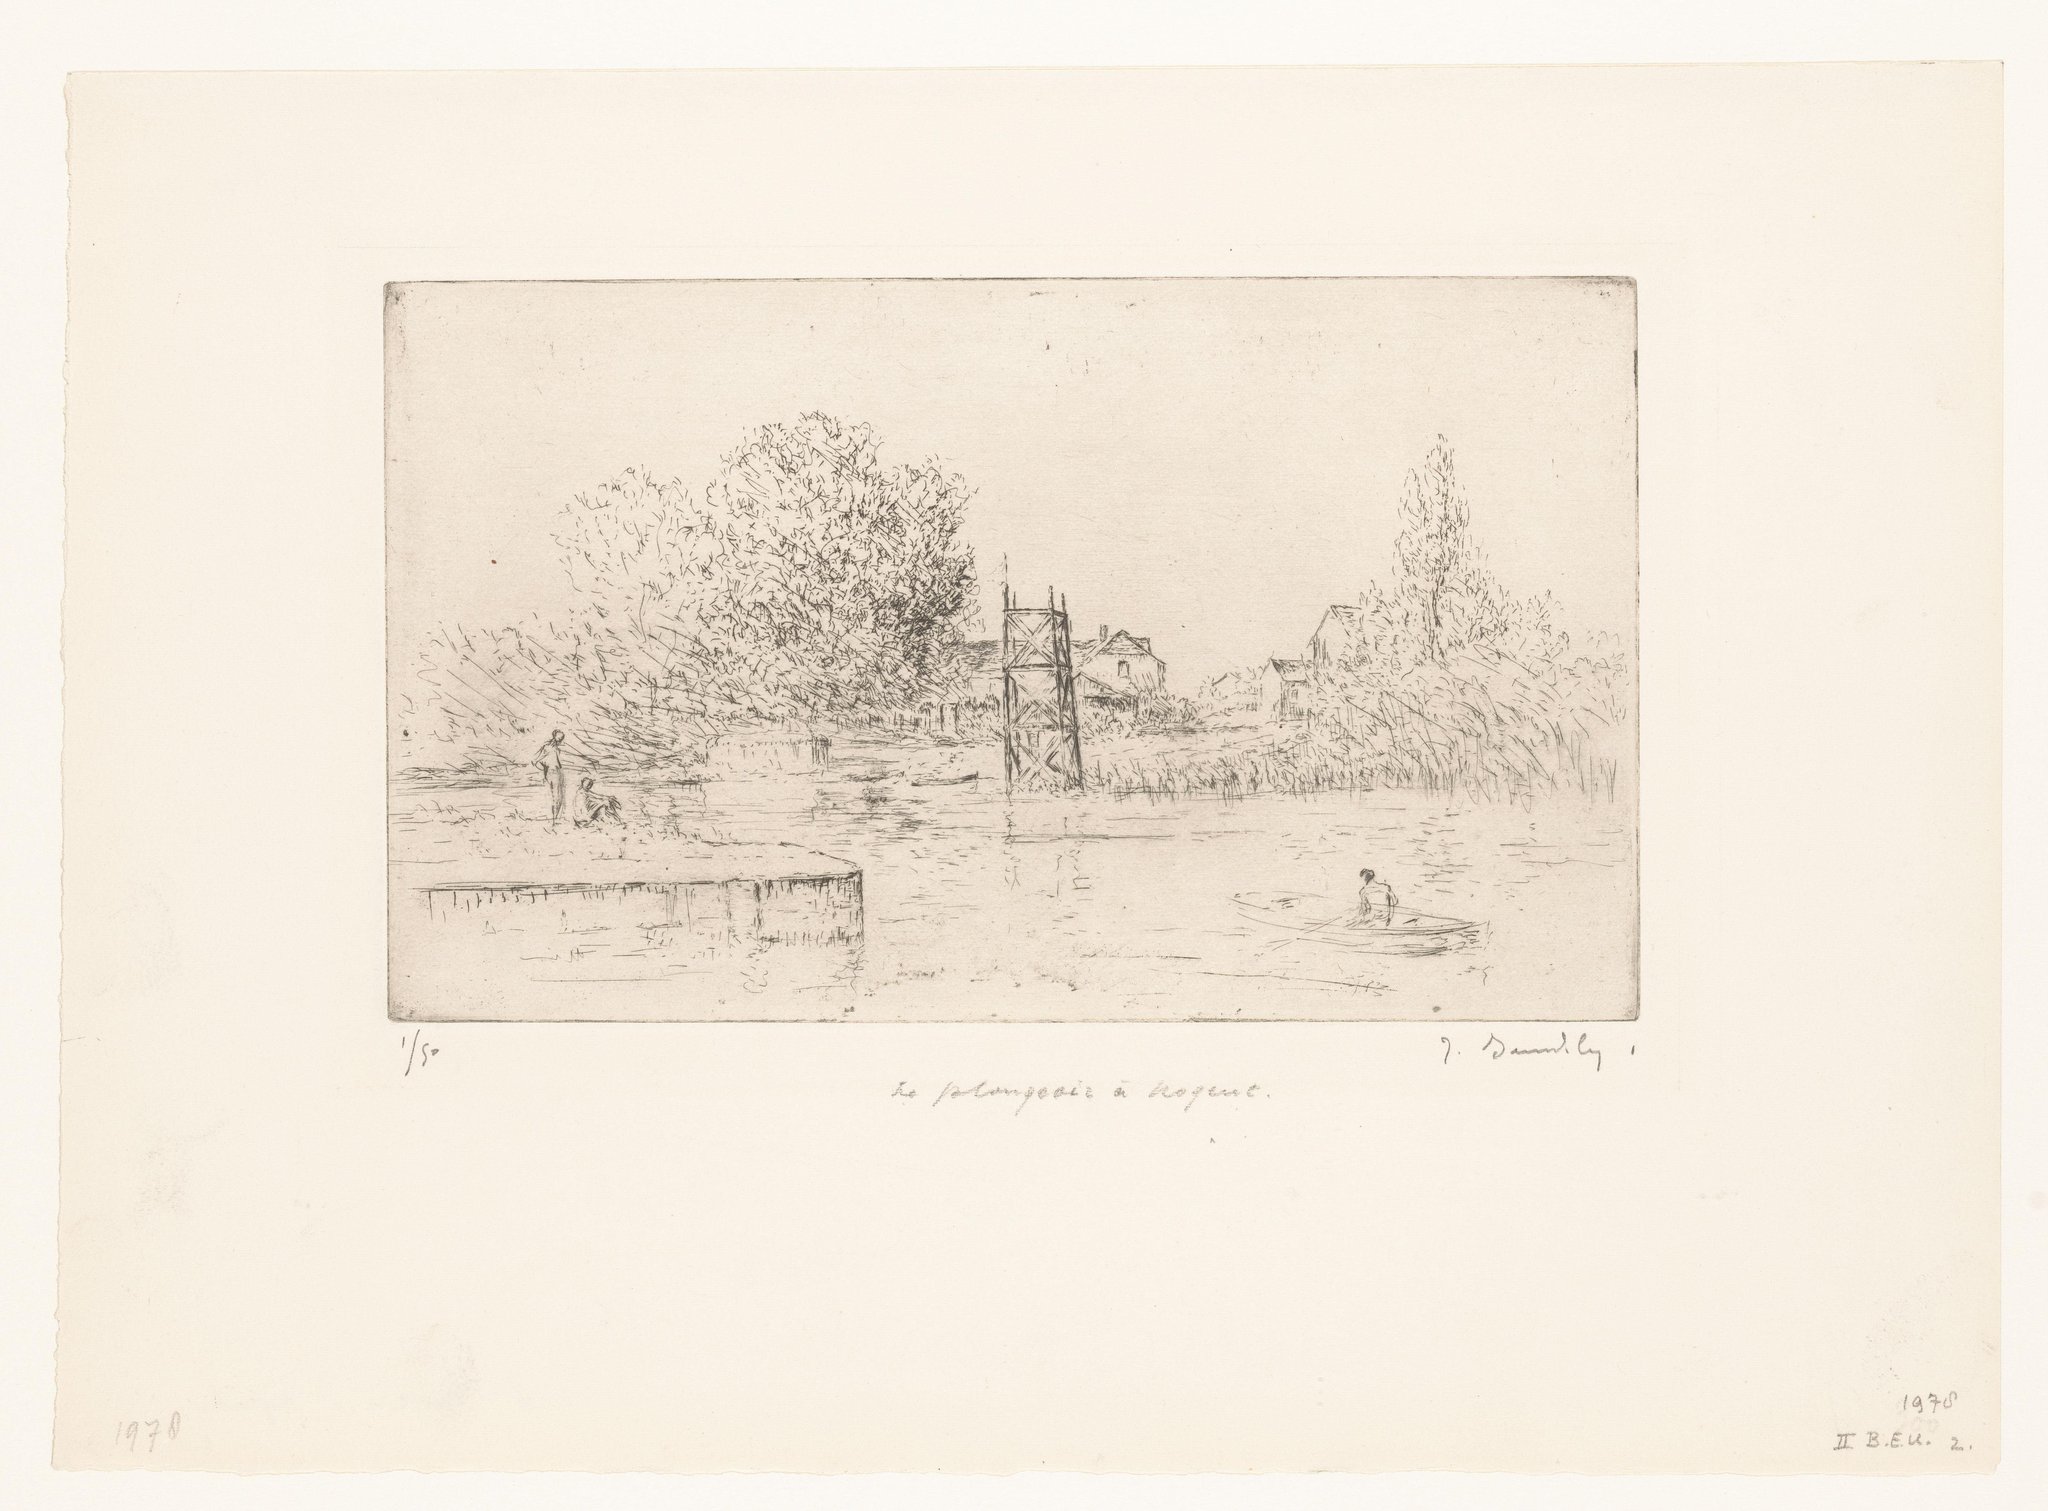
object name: print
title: Le plangeoir à Nogent.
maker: jacques beurdeley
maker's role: print maker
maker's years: 1874-1954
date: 1884-1954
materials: paper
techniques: drypoint, etching, intaglio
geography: france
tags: landscapes with waters, waterscapes, seascapes (in the temperate zone), rowing-boat, canoe, etc.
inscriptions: watermark, collector's mark: Lugt 2760, collector's mark: Lugt 2228, collector's mark: Lugt 4730